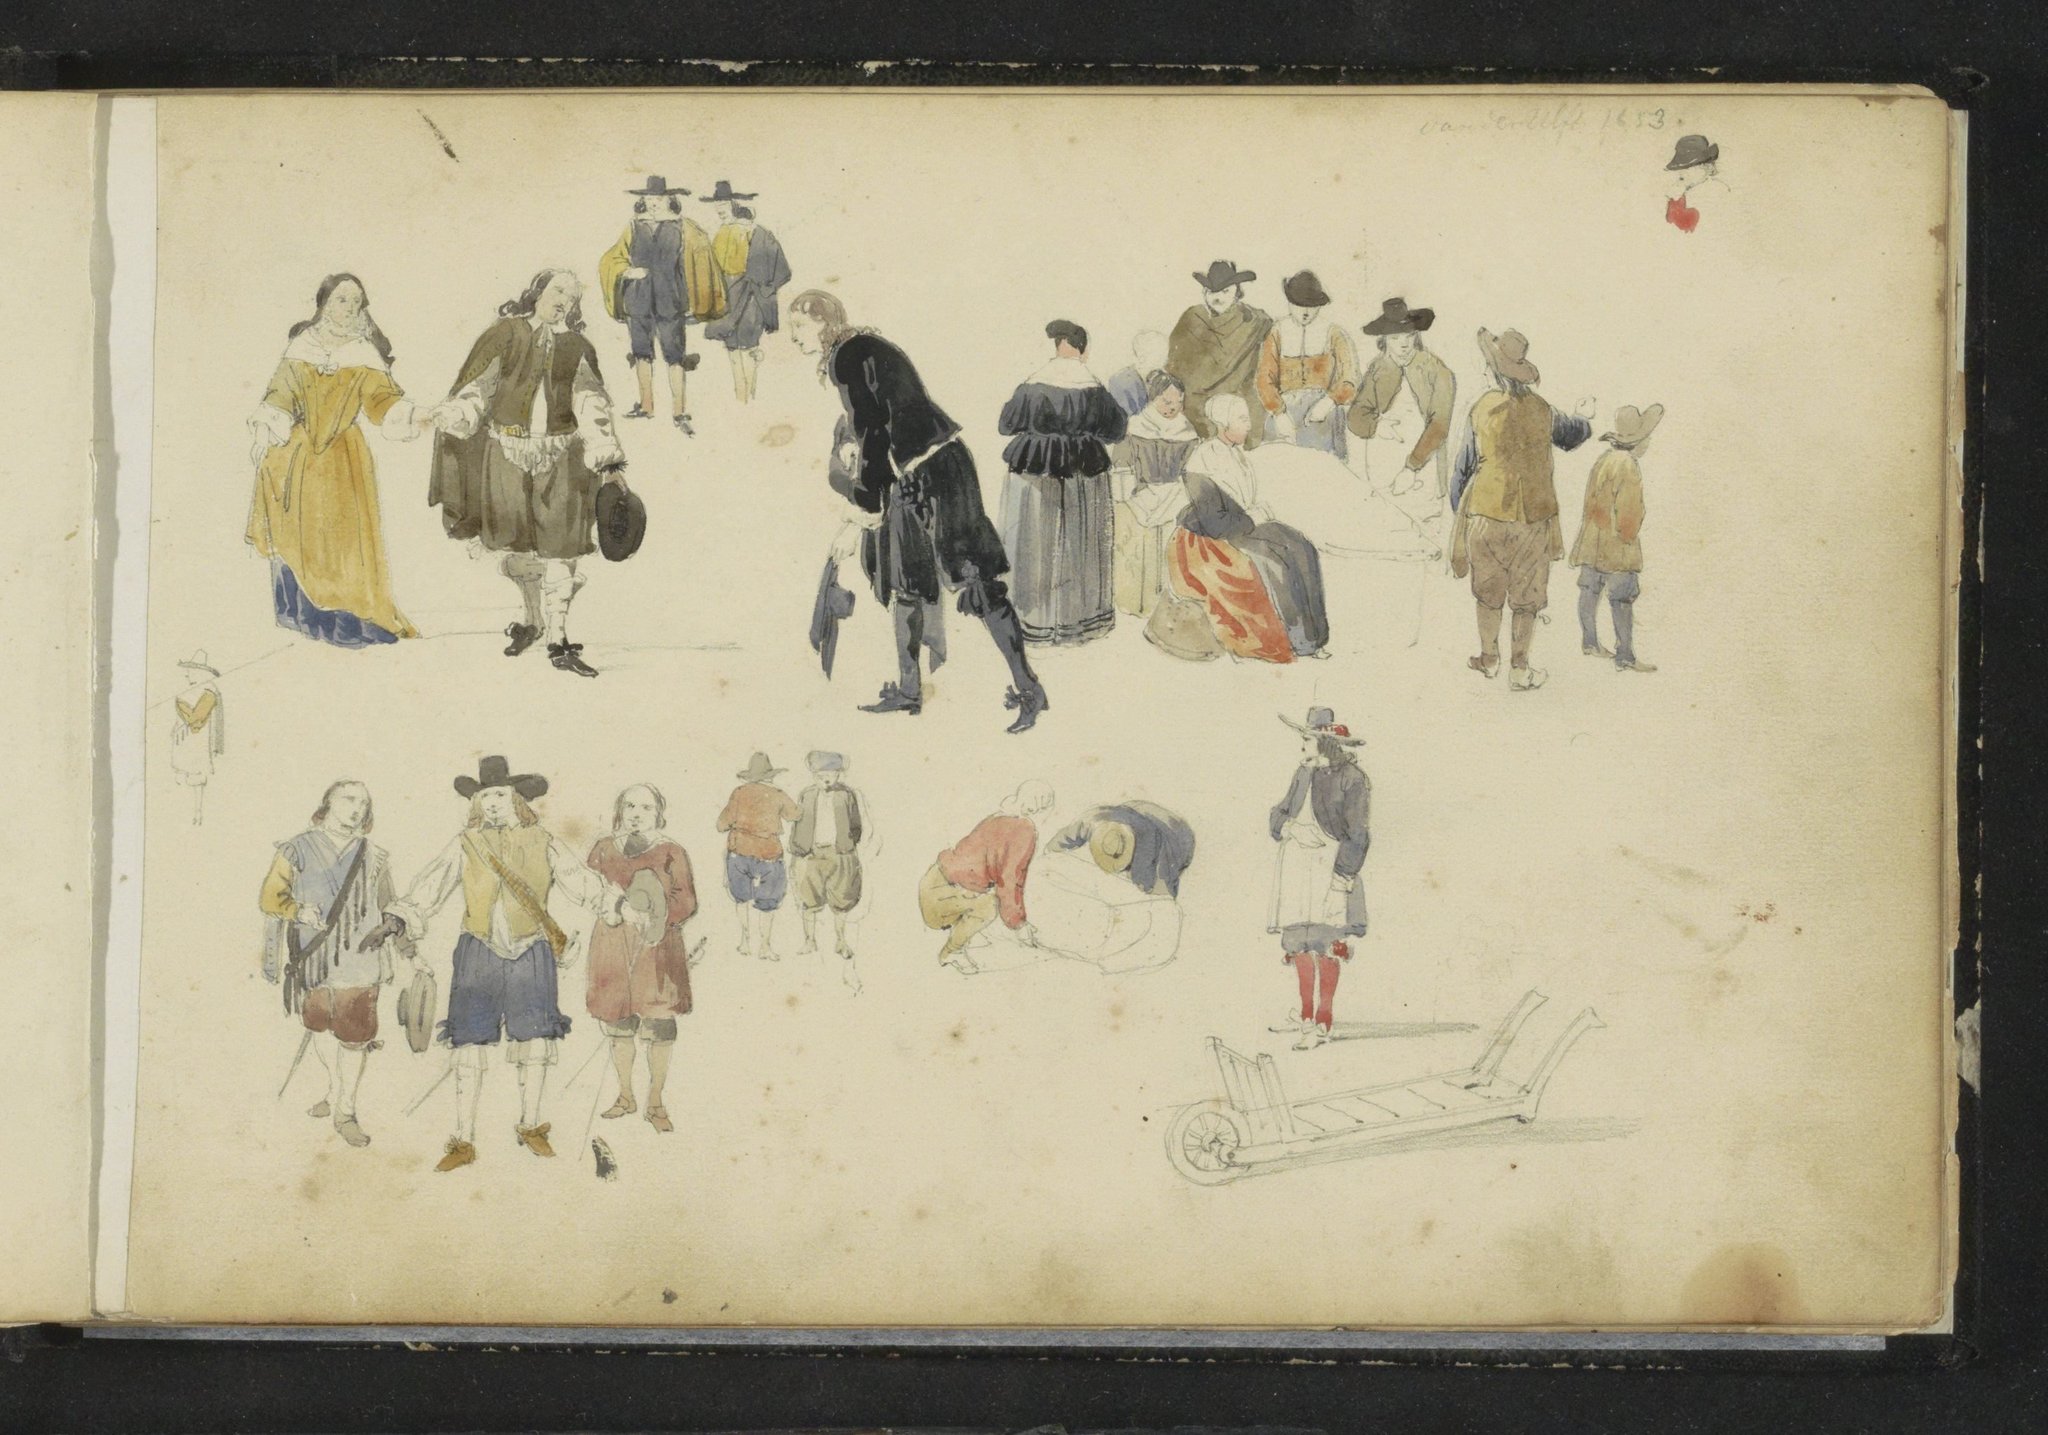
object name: sketchbook leaf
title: Figuren in zeventiende-eeuwse kleding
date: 1846-1882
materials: paper, pencil, watercolor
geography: netherlands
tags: adult woman, adult man, clothes, costume (+ women's clothes), clothes, costume (+ men's clothes)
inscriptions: annotation: ‘van der Ulft 1653’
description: Figuren in zeventiende-eeuwse kleding. Blad 9 uit een schetsboek met 91 bladen.